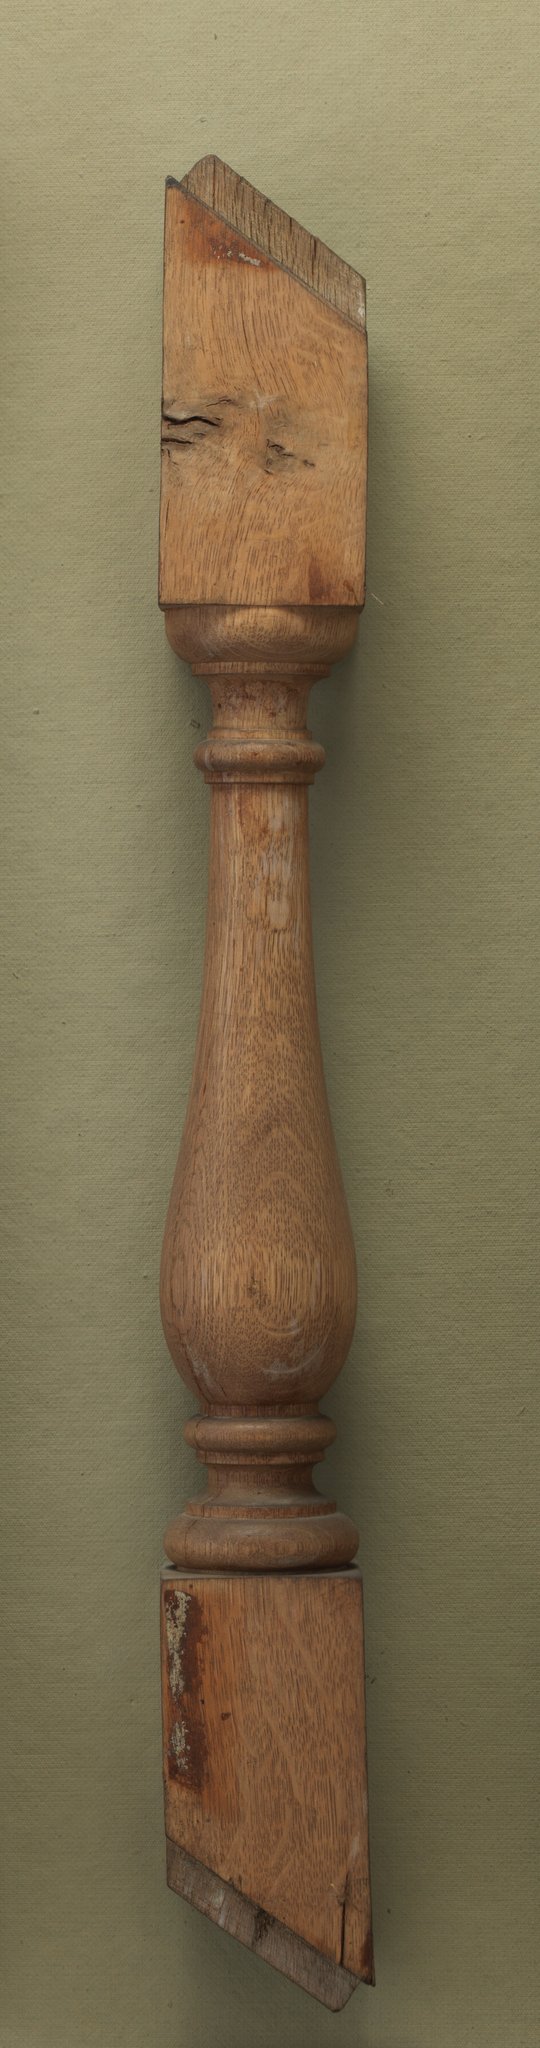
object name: baluster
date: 1701-1733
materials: wood